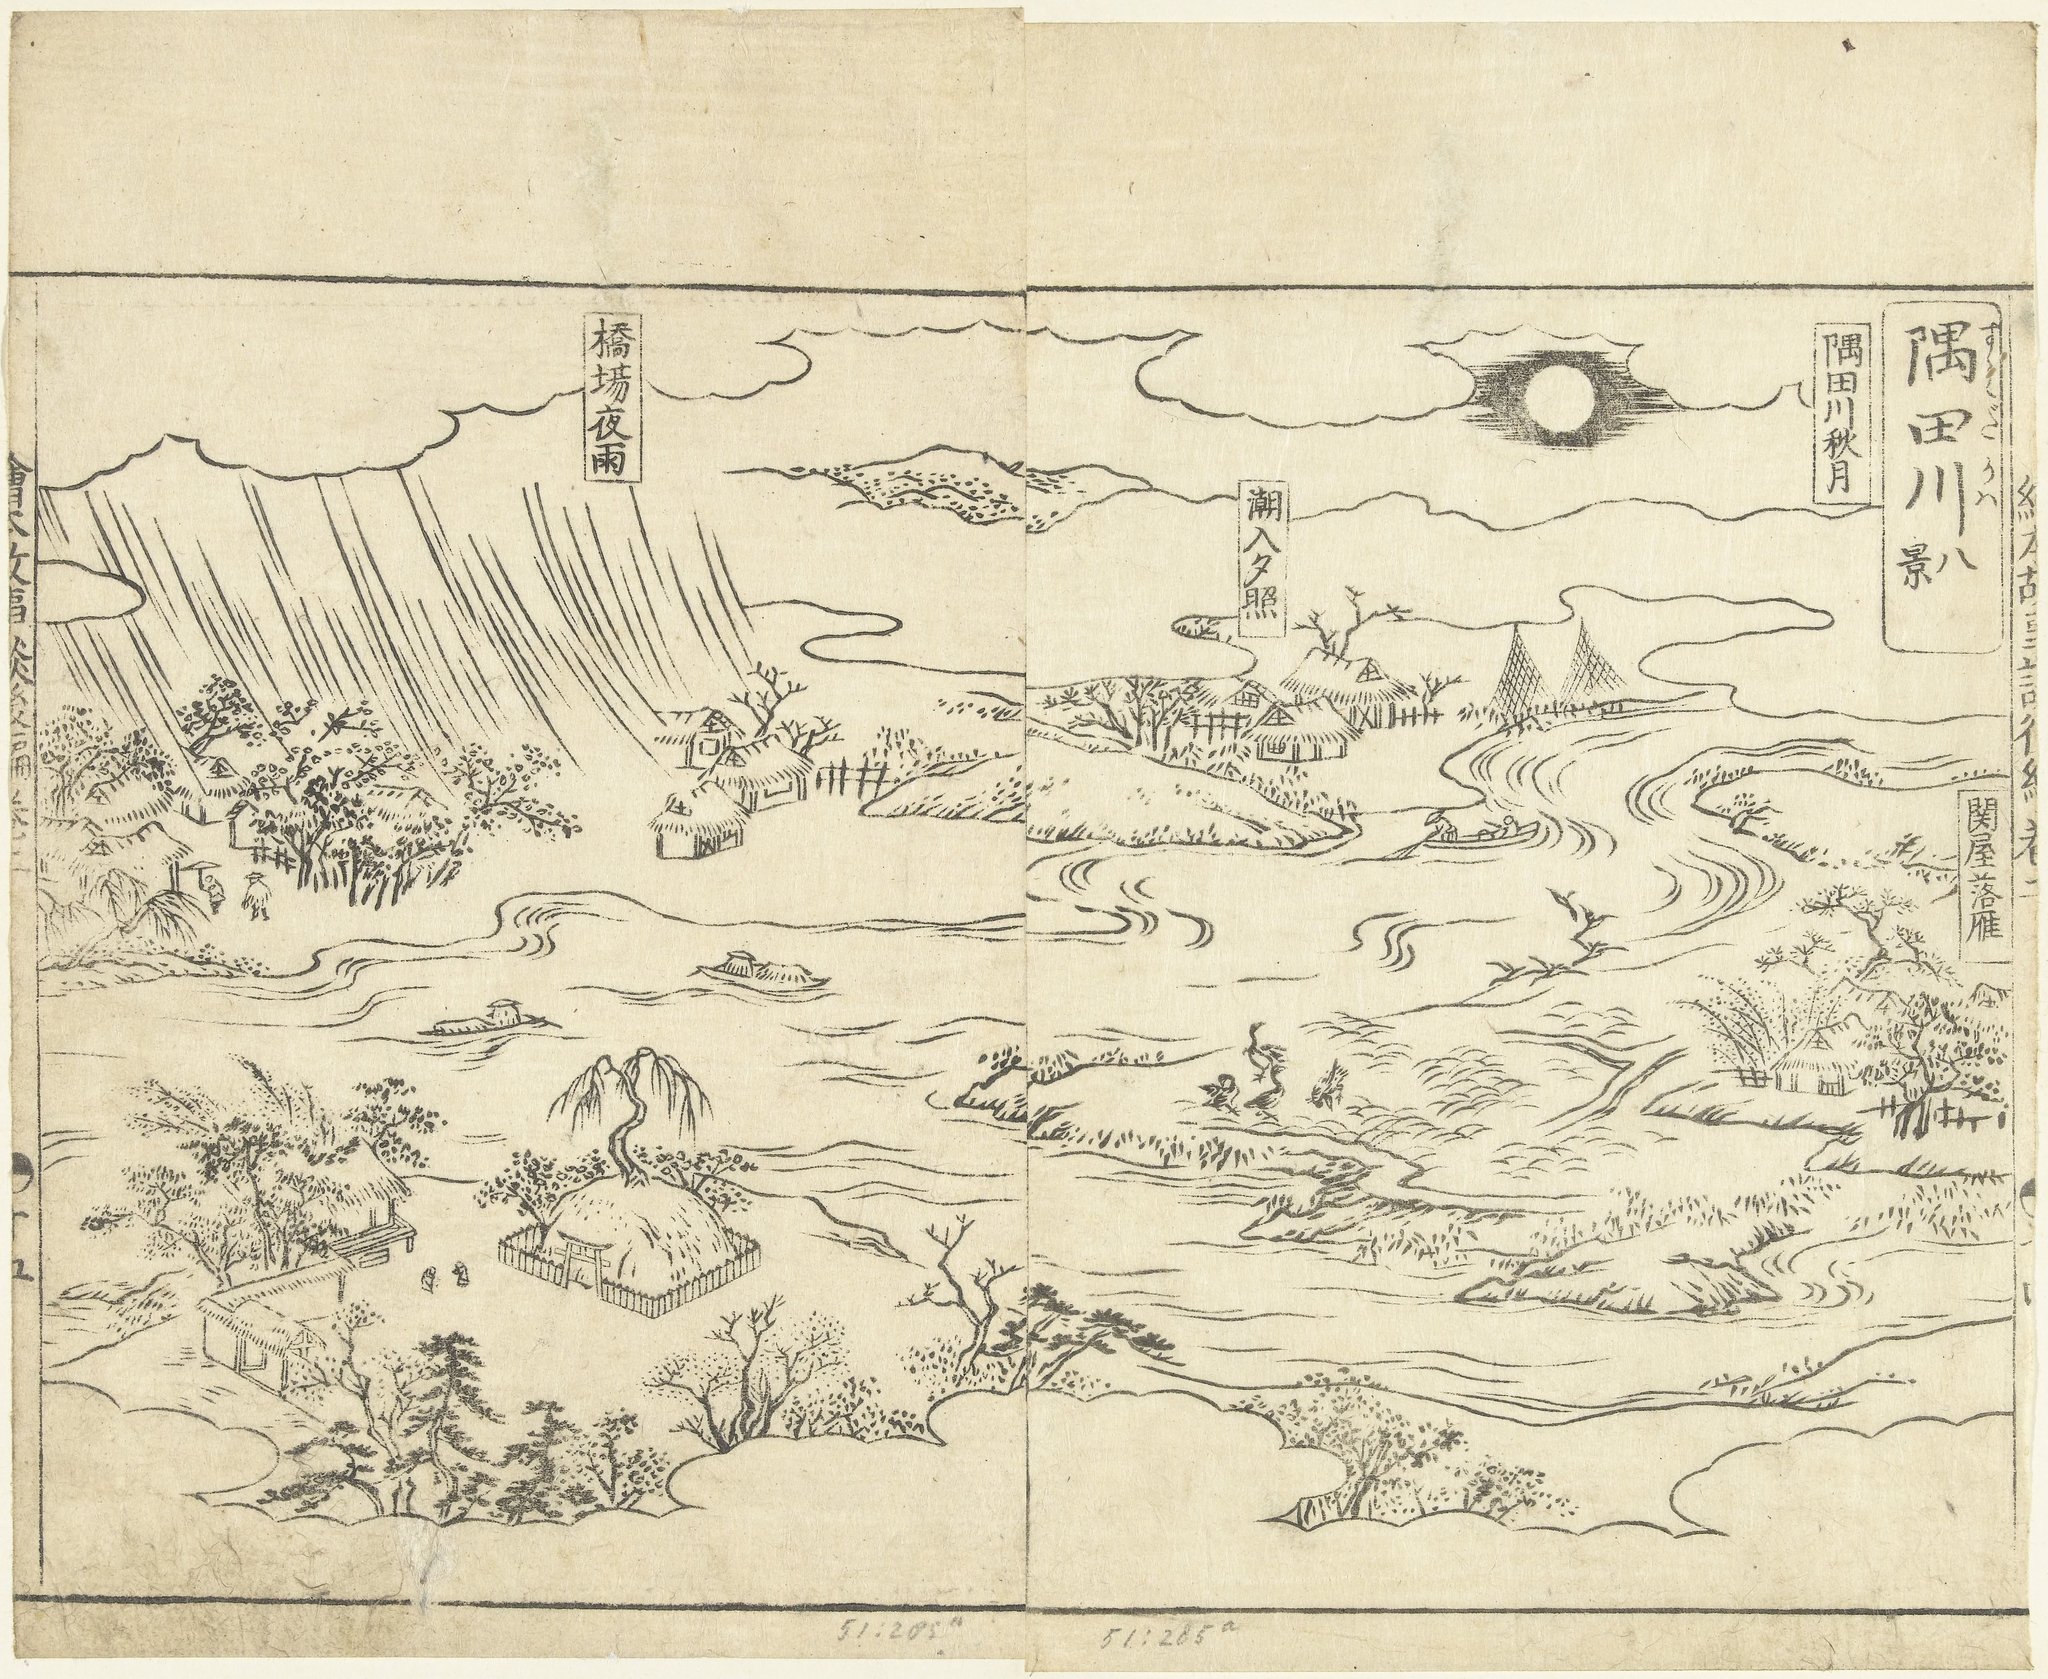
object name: print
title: Ehon kojidan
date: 1714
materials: paper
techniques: woodcut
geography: osaka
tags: landscapes, river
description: Rivierlandschap met in de rechthoekige cartouches vier van de acht klassieke landschapstitels: herfstmaan, avondklokken, avondregen en neerstrijkende ganzen. Twee pagina`s, aan elkaar geplakt, uit het Japanse boek Ehon kodanji.